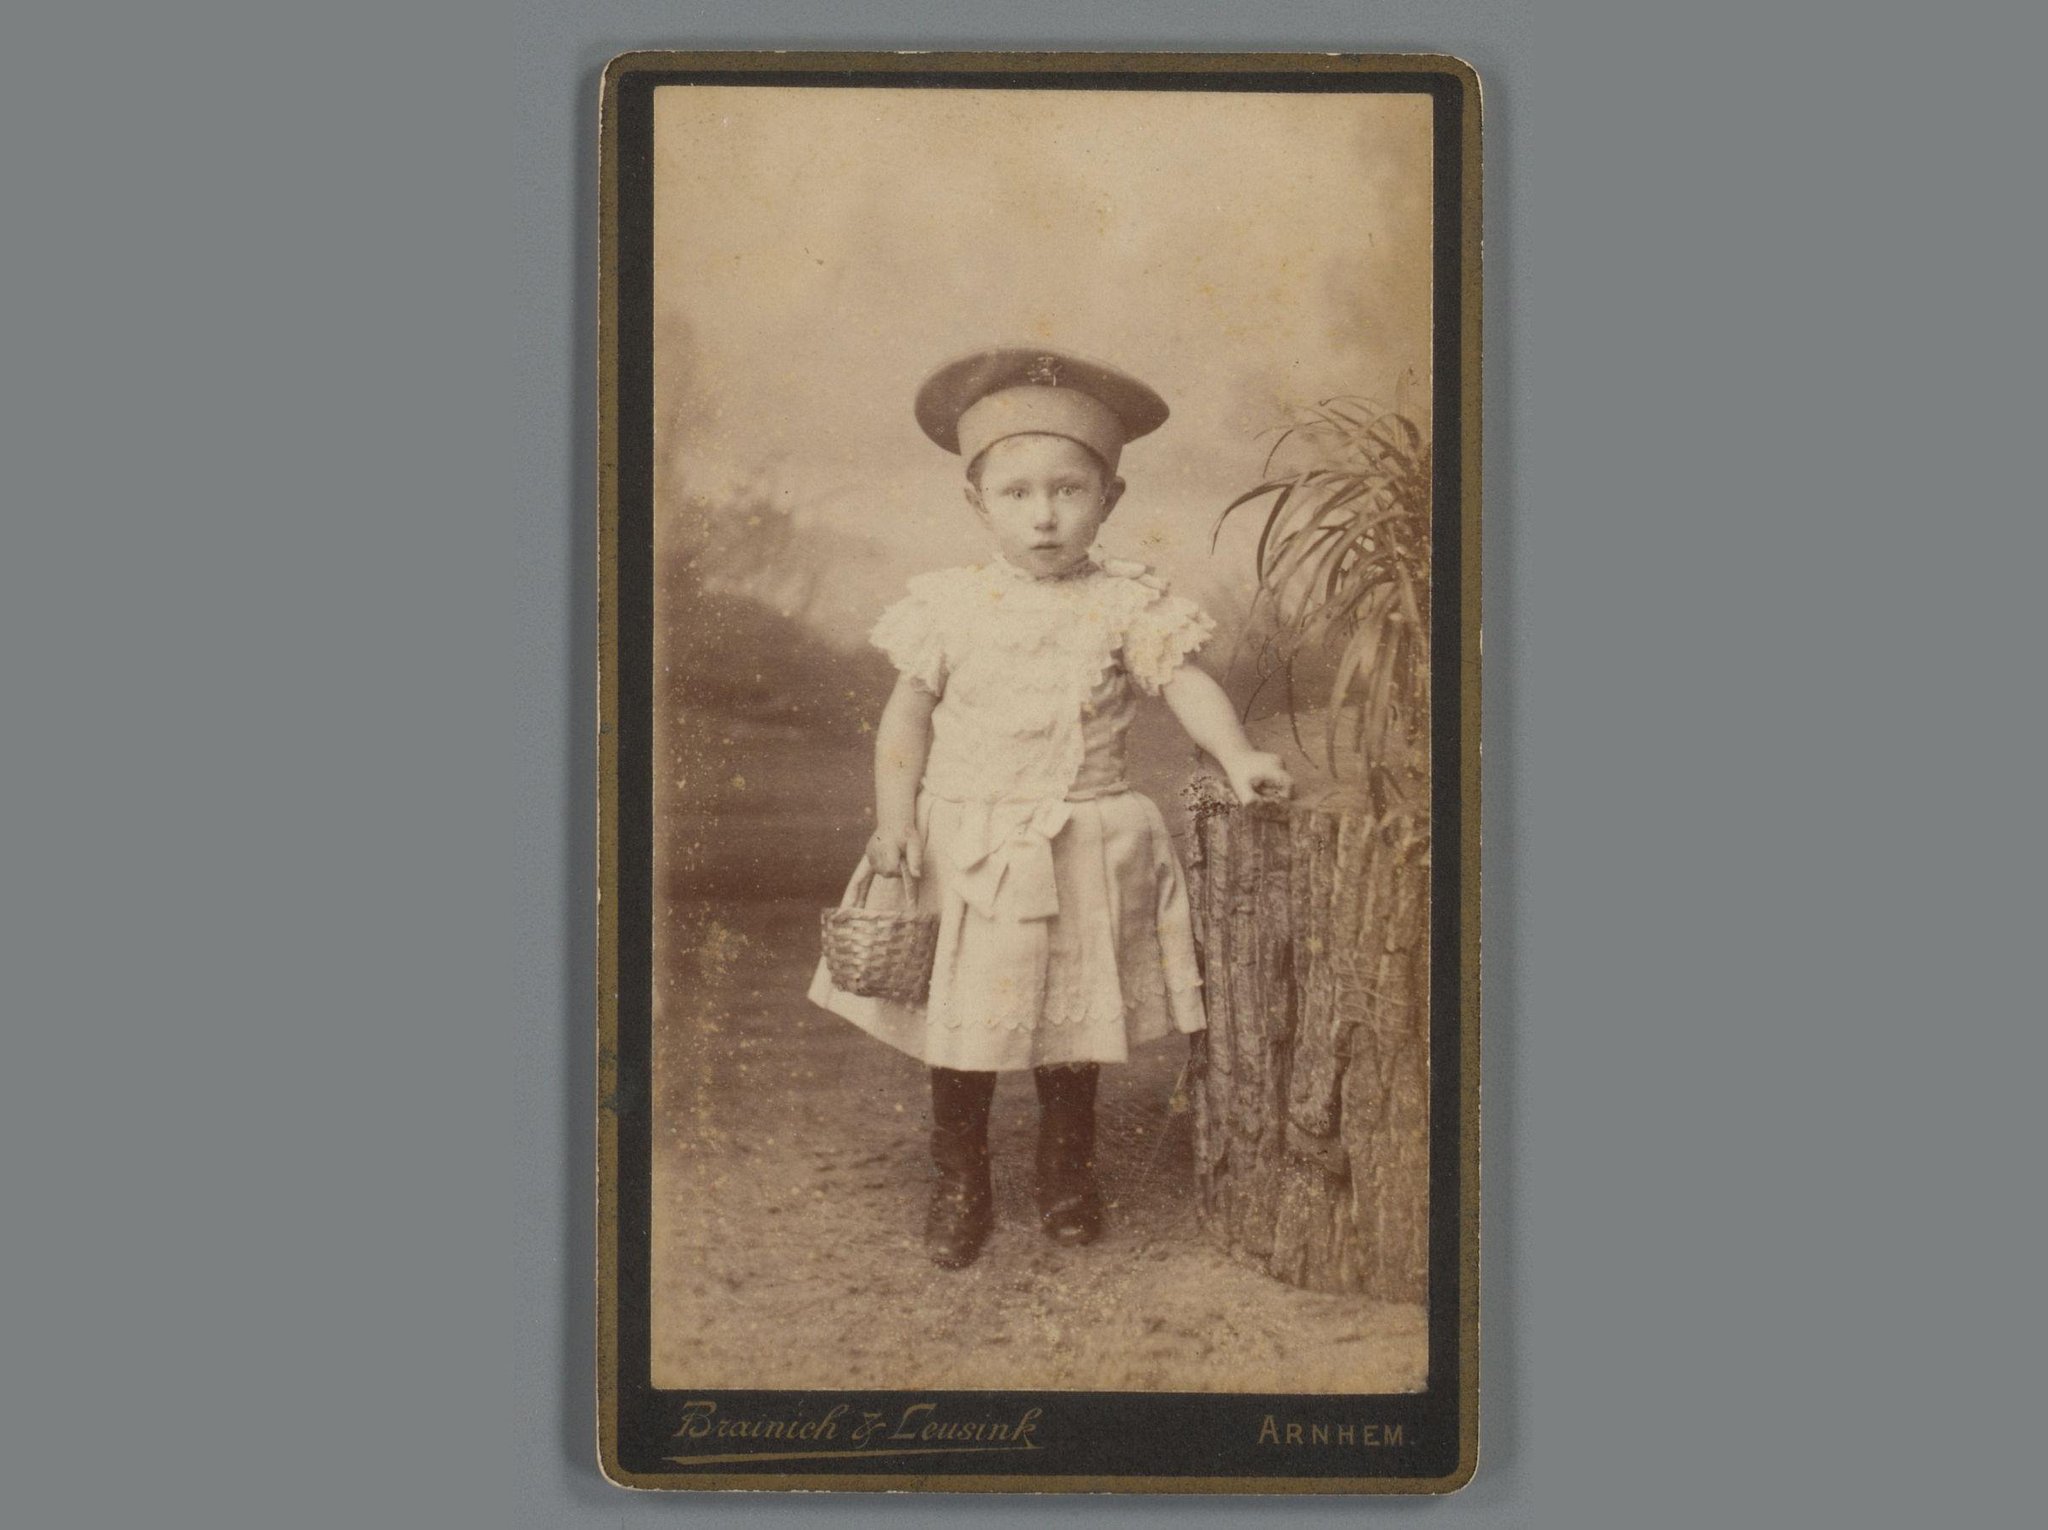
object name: carte de visite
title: Portret van een onbekend kind met een mand uit de familie en de kring van Eugene van Delden en Belle van Delden-Denninghof Stelling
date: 1881-1904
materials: cardboard, paper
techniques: albumen print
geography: arnhem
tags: child, container made of plant material other than wood: basket, historical persons not known by name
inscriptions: inscription: ‘PHOTOGRAPHISCH/ Atelier/ van/ BRAINICH & LEUSINK/ Mentenstraat No. 10/ ARNHEM/ De platen blijven voor nabestelling bewaard, ook worden/ vergrootingen naar ieder klein portret vervaardigd.’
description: Portret uit de kring van Eugene van Delden (Hartapoera, 1865 - Den Haag, 1954) en Belle van Delden-Denninghof Stelling (Batavia, 1870 - Den Haag, 1947).